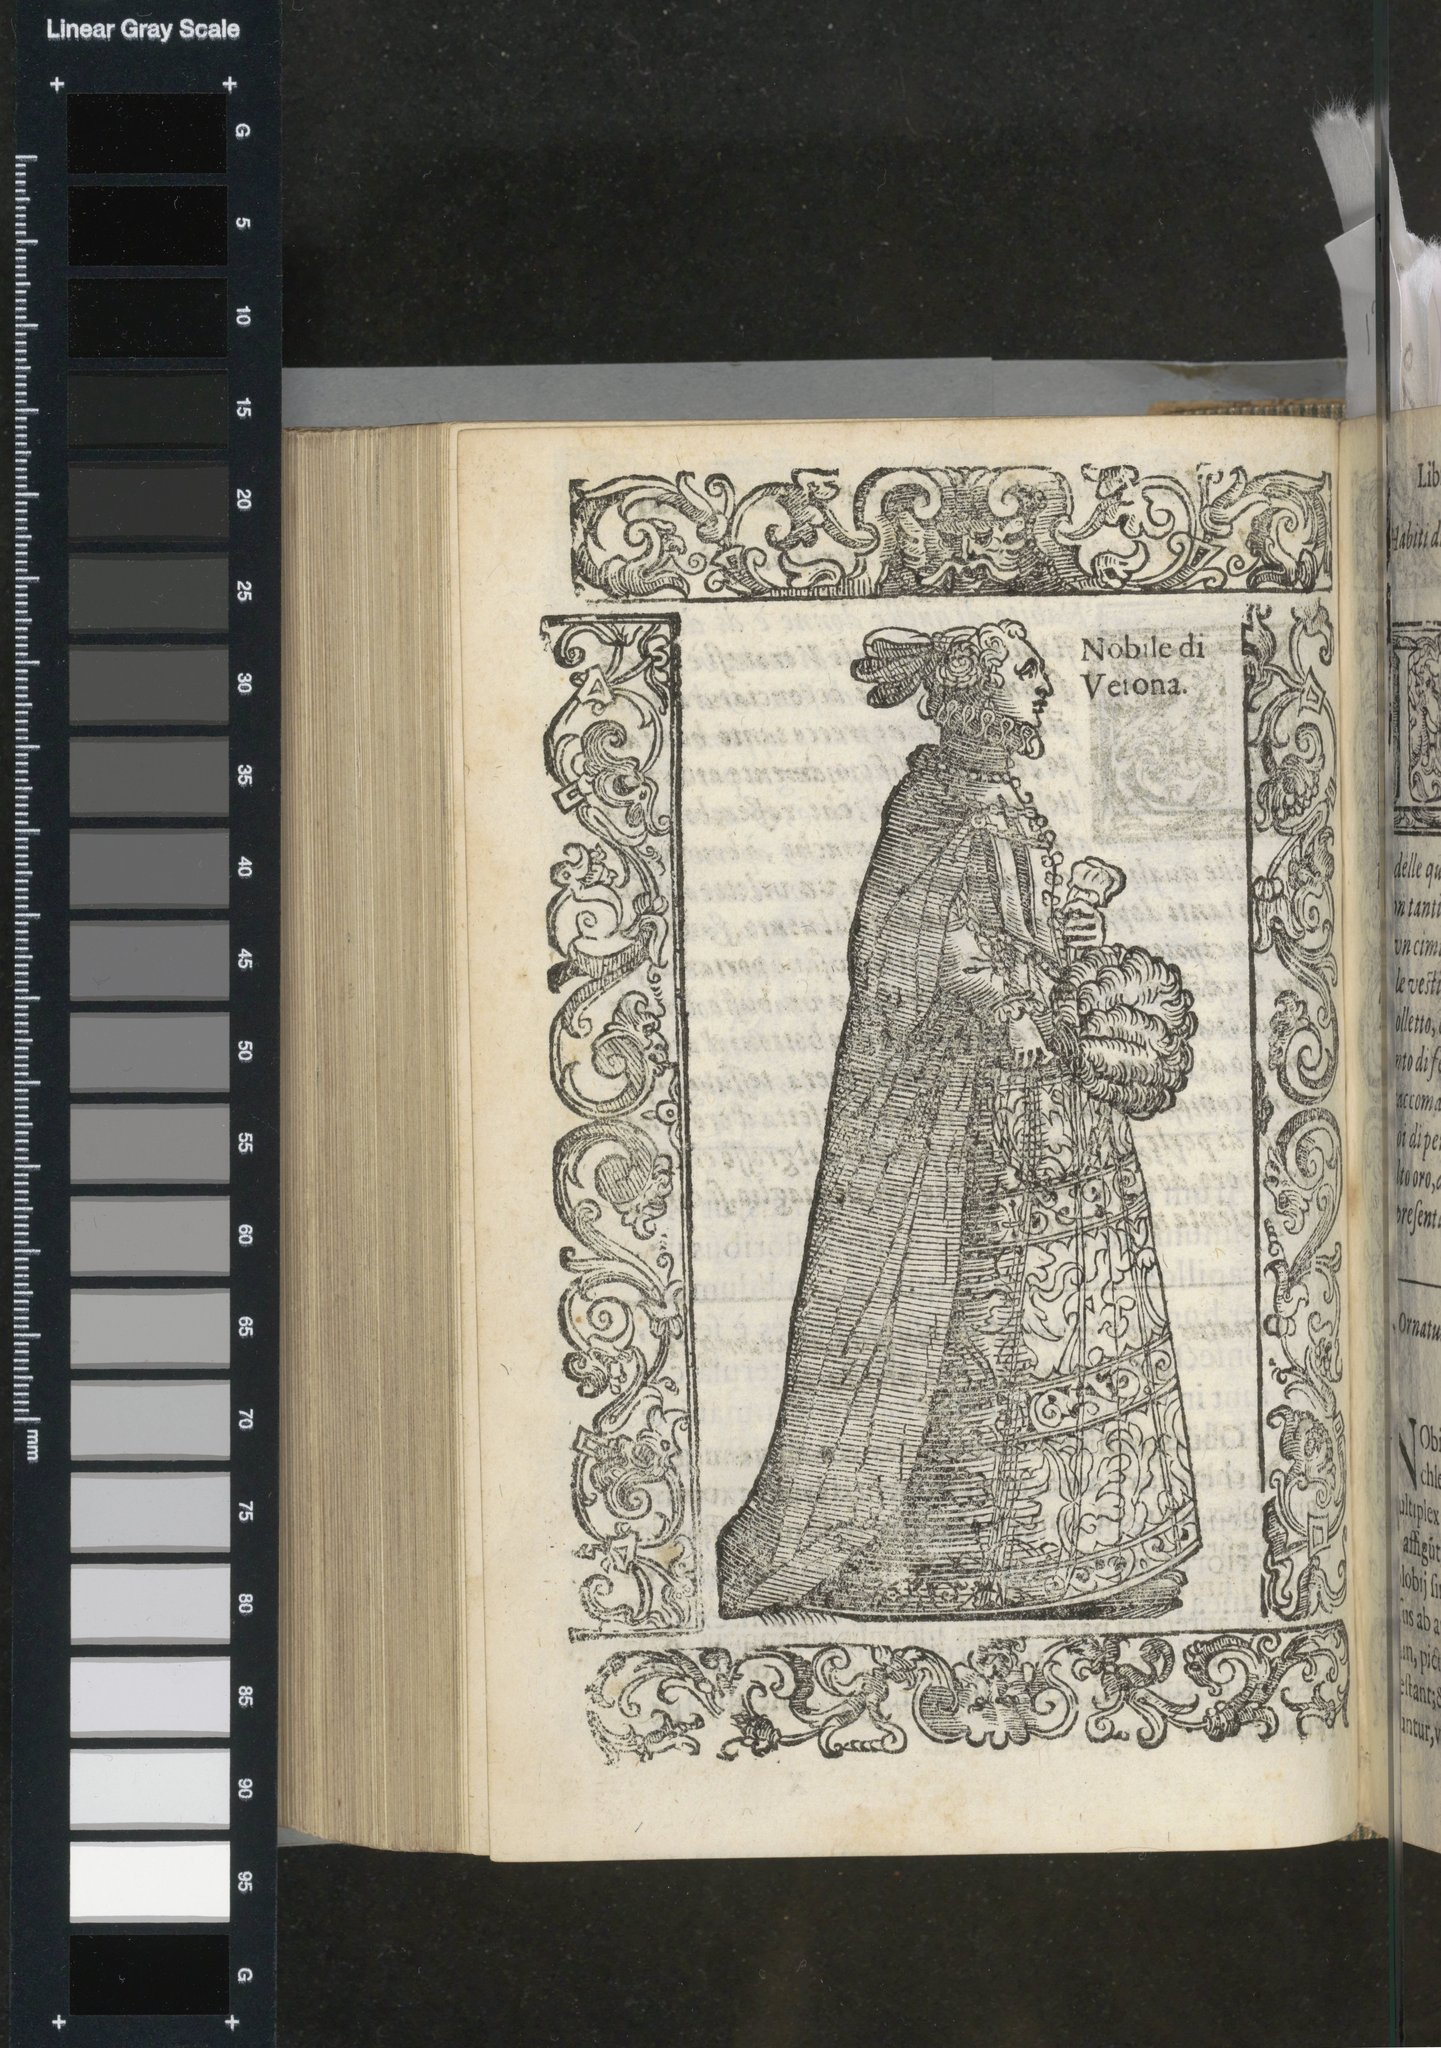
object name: costume print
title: Nobile di verona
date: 1598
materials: paper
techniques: woodcut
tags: fashion plates